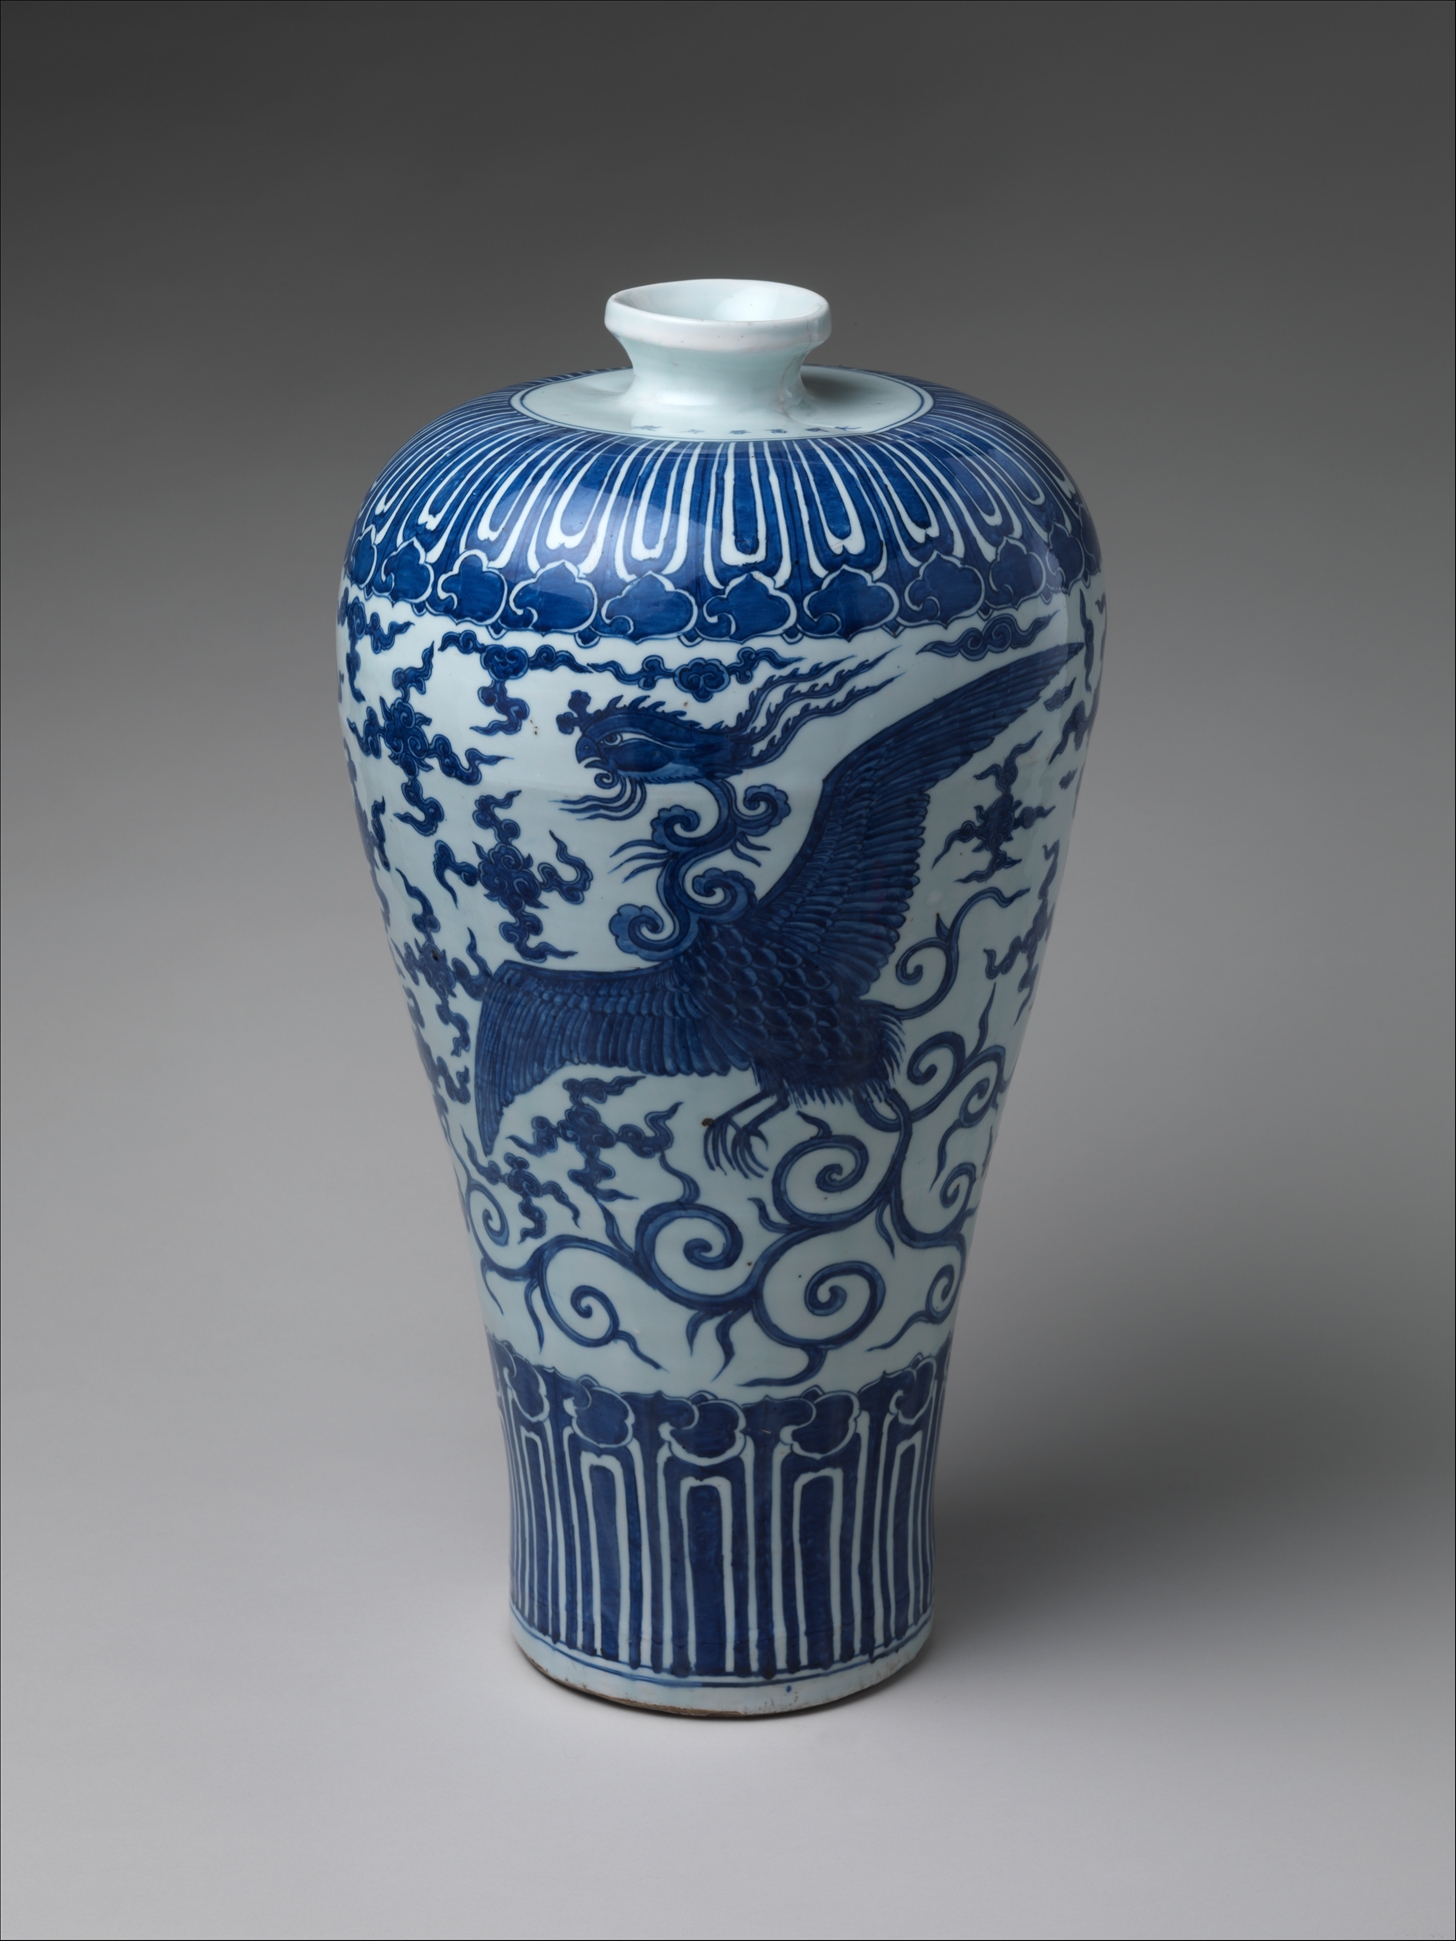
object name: vase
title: Vase in Meiping Shape with Phoenix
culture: chinese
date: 1567-1633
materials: cobalt, glaze, porcelain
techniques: painting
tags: dragons